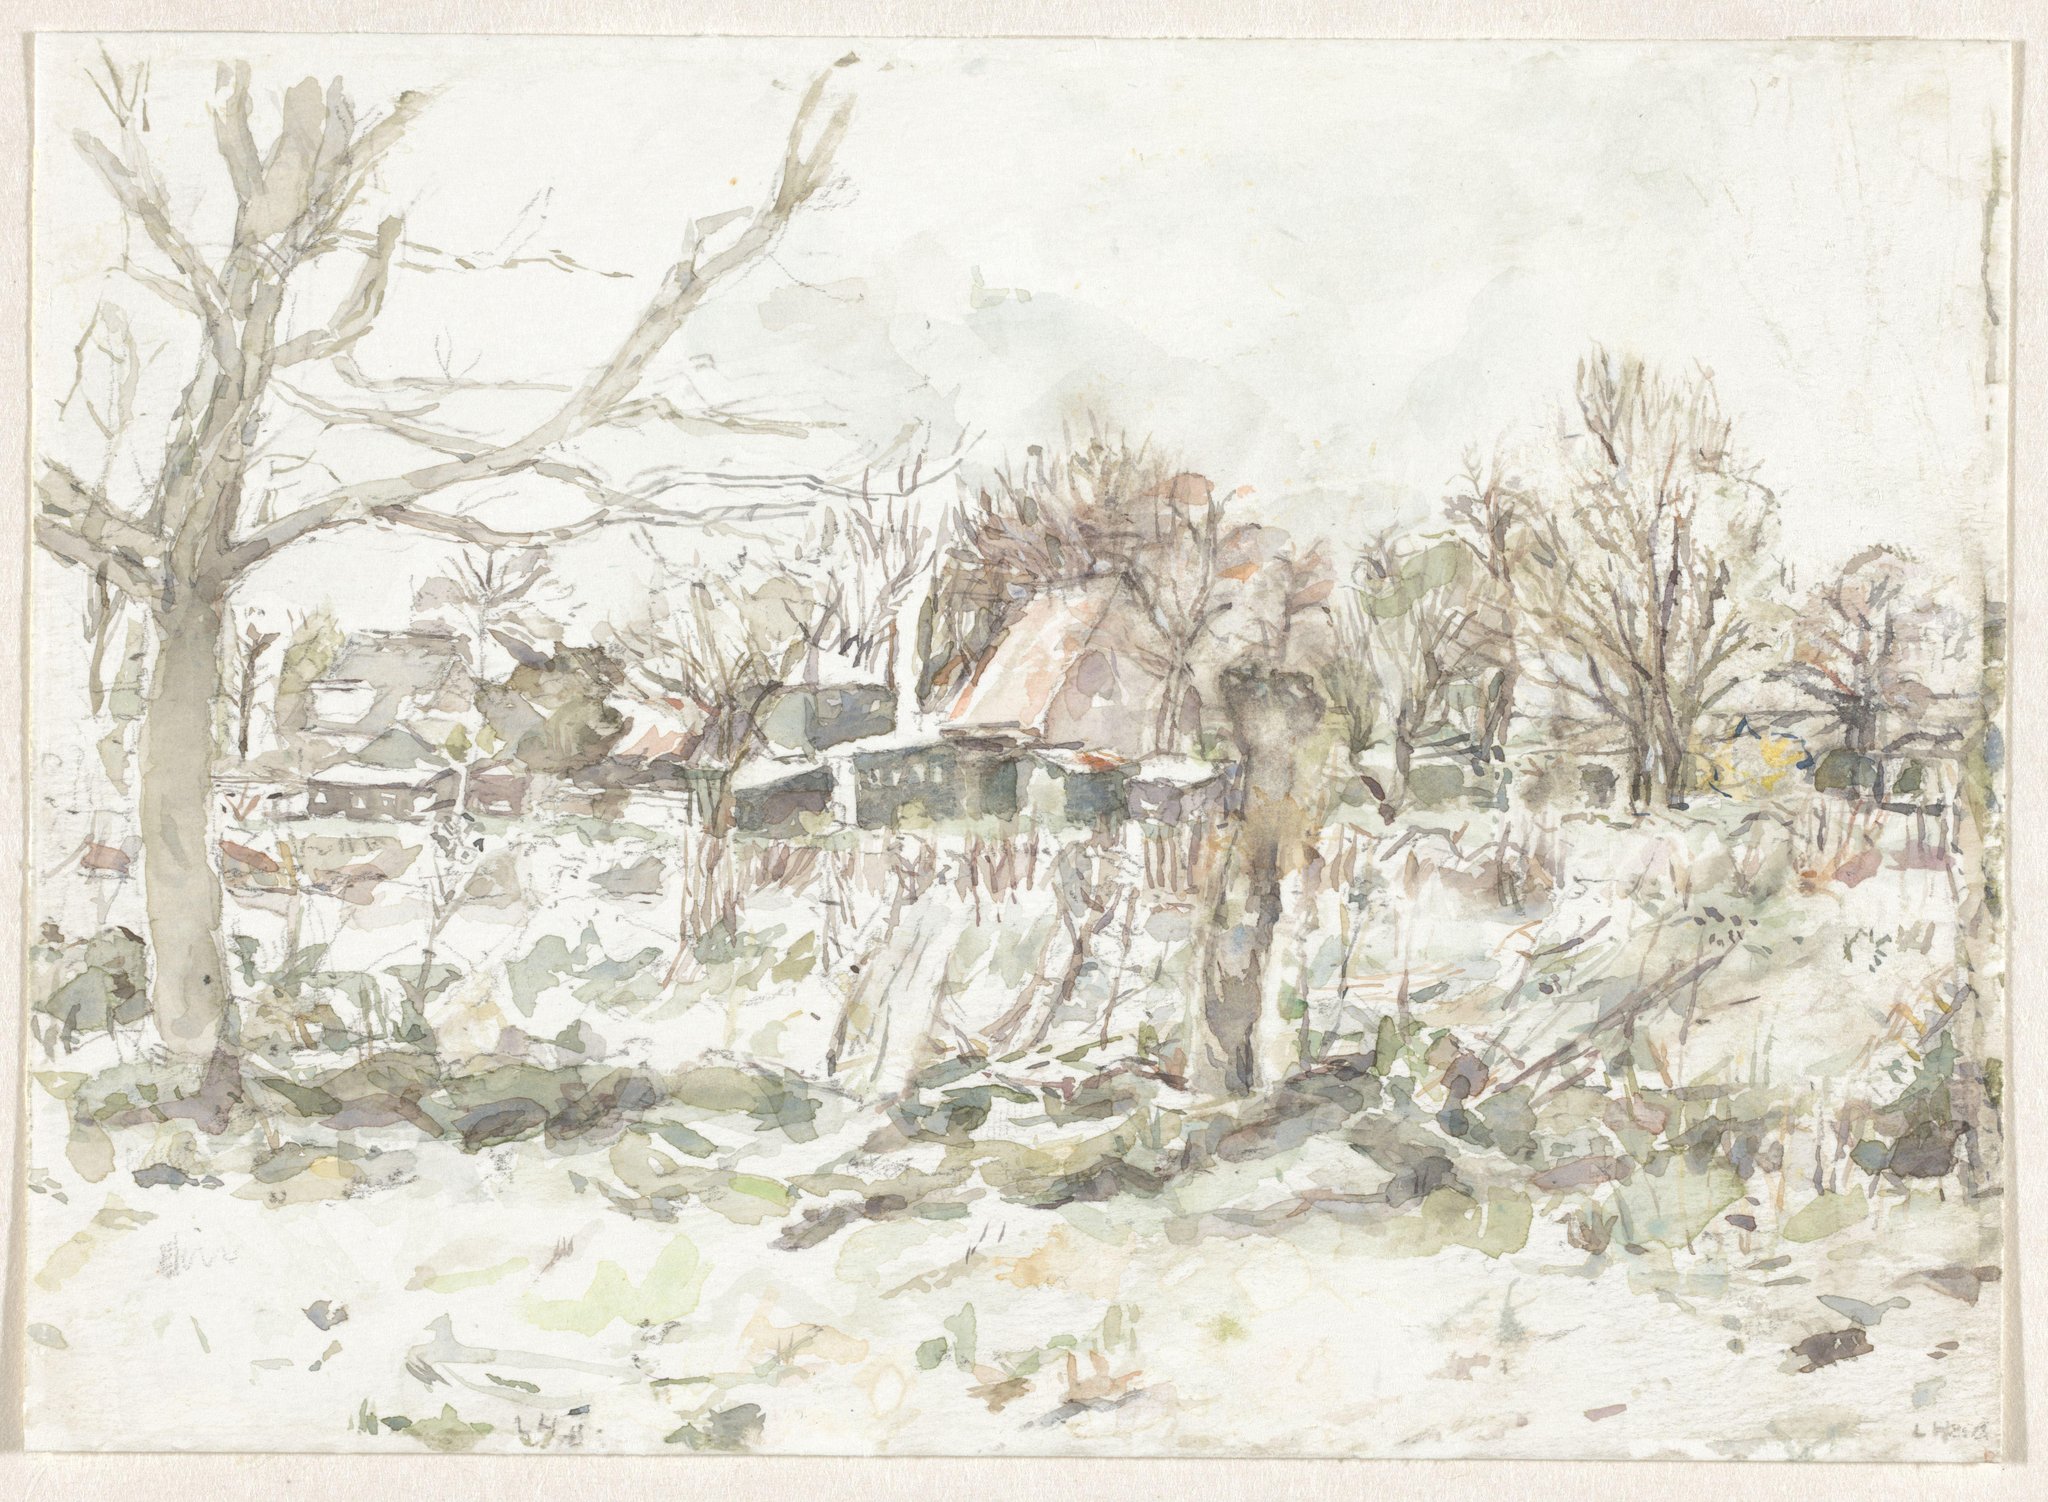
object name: watercolor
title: Middelpolder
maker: lau heidendael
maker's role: print maker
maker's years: 1946-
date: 2009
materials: paper, watercolor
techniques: brush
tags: polder, reclaimed land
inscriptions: title: ‘middelpolder’, signature: ‘L. Heidend’, signature: ‘L.Heid’